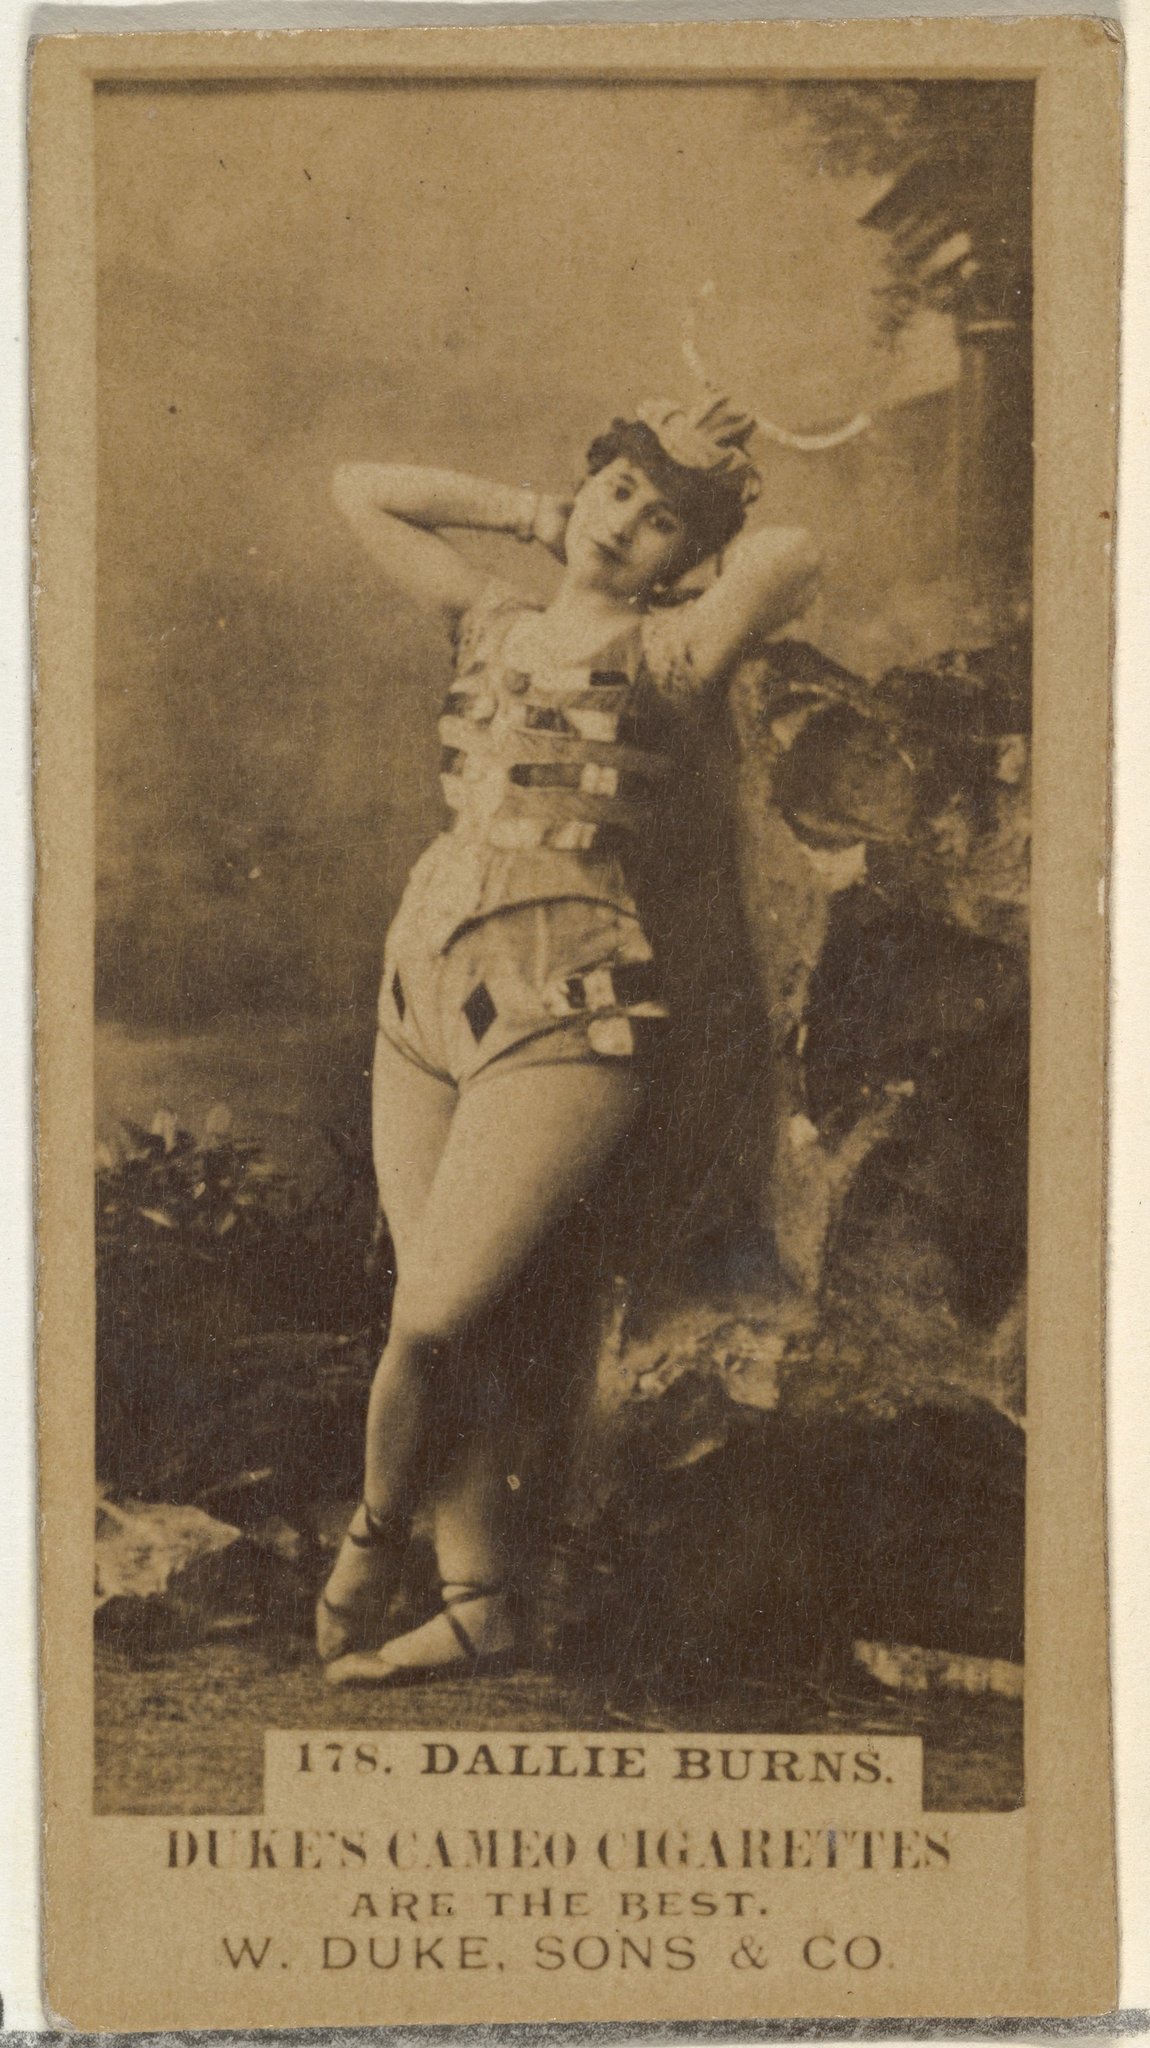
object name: photograph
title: Card Number 178, Dallie Burns, from the Actors and Actresses series (N145-5) issued by Duke Sons & Co. to promote Cameo Cigarettes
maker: w. duke, sons & co.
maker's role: publisher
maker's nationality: american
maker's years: 1870-1920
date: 1880-1889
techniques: albumen silver print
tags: portraits,women,actresses